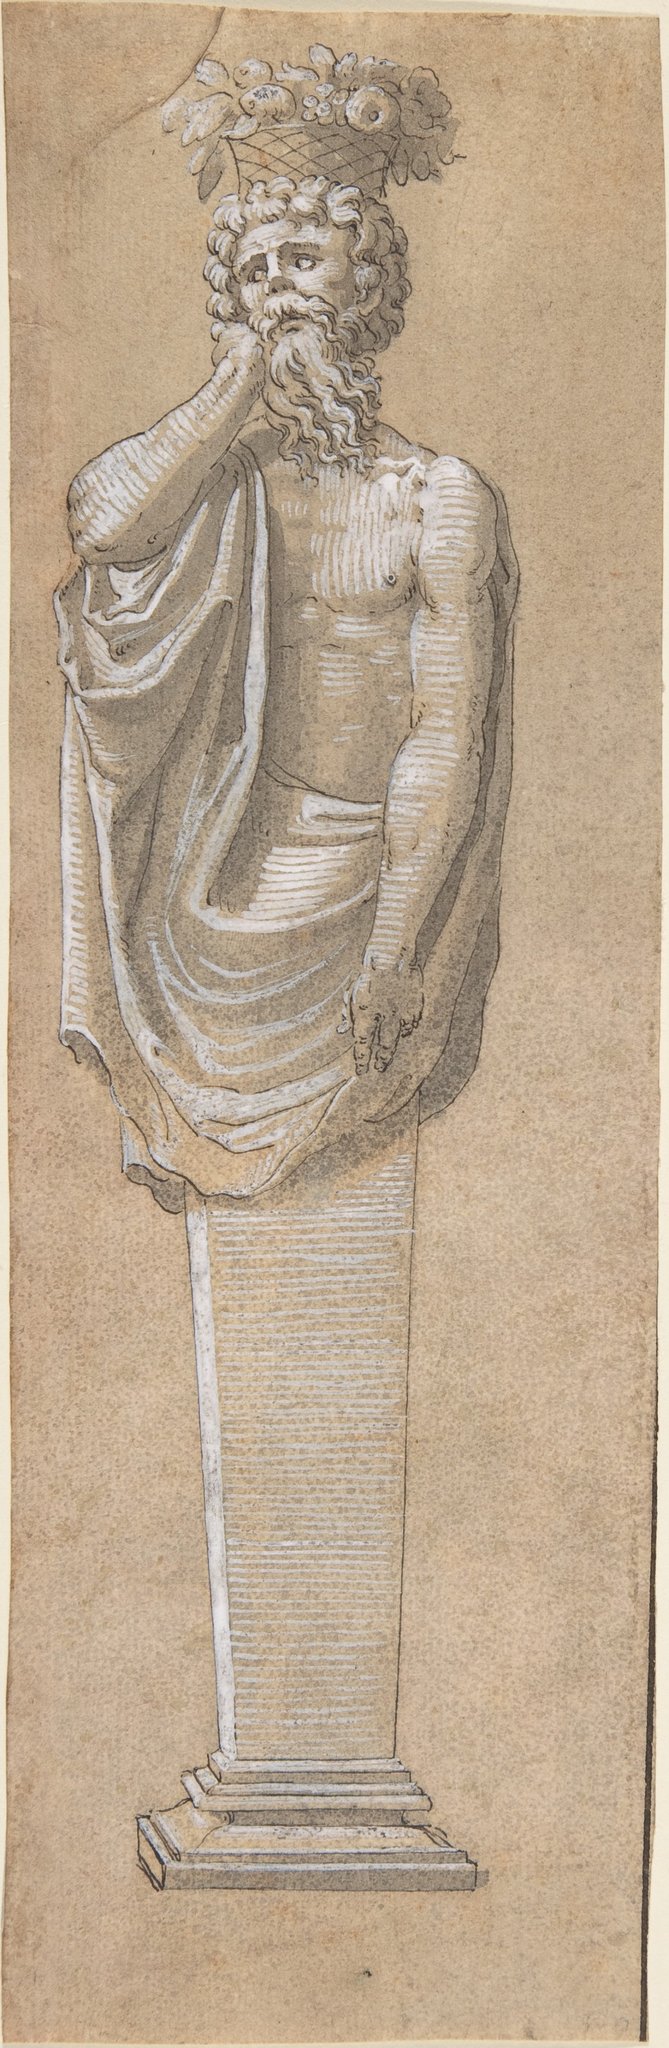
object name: drawing ornament architecture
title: Bearded Male Term with a Raised Left Arm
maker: anonymous, french, 16th century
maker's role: artist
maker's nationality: french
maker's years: 1500-1600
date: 1545-1565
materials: ink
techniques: heightening, pen, wash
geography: italy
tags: men